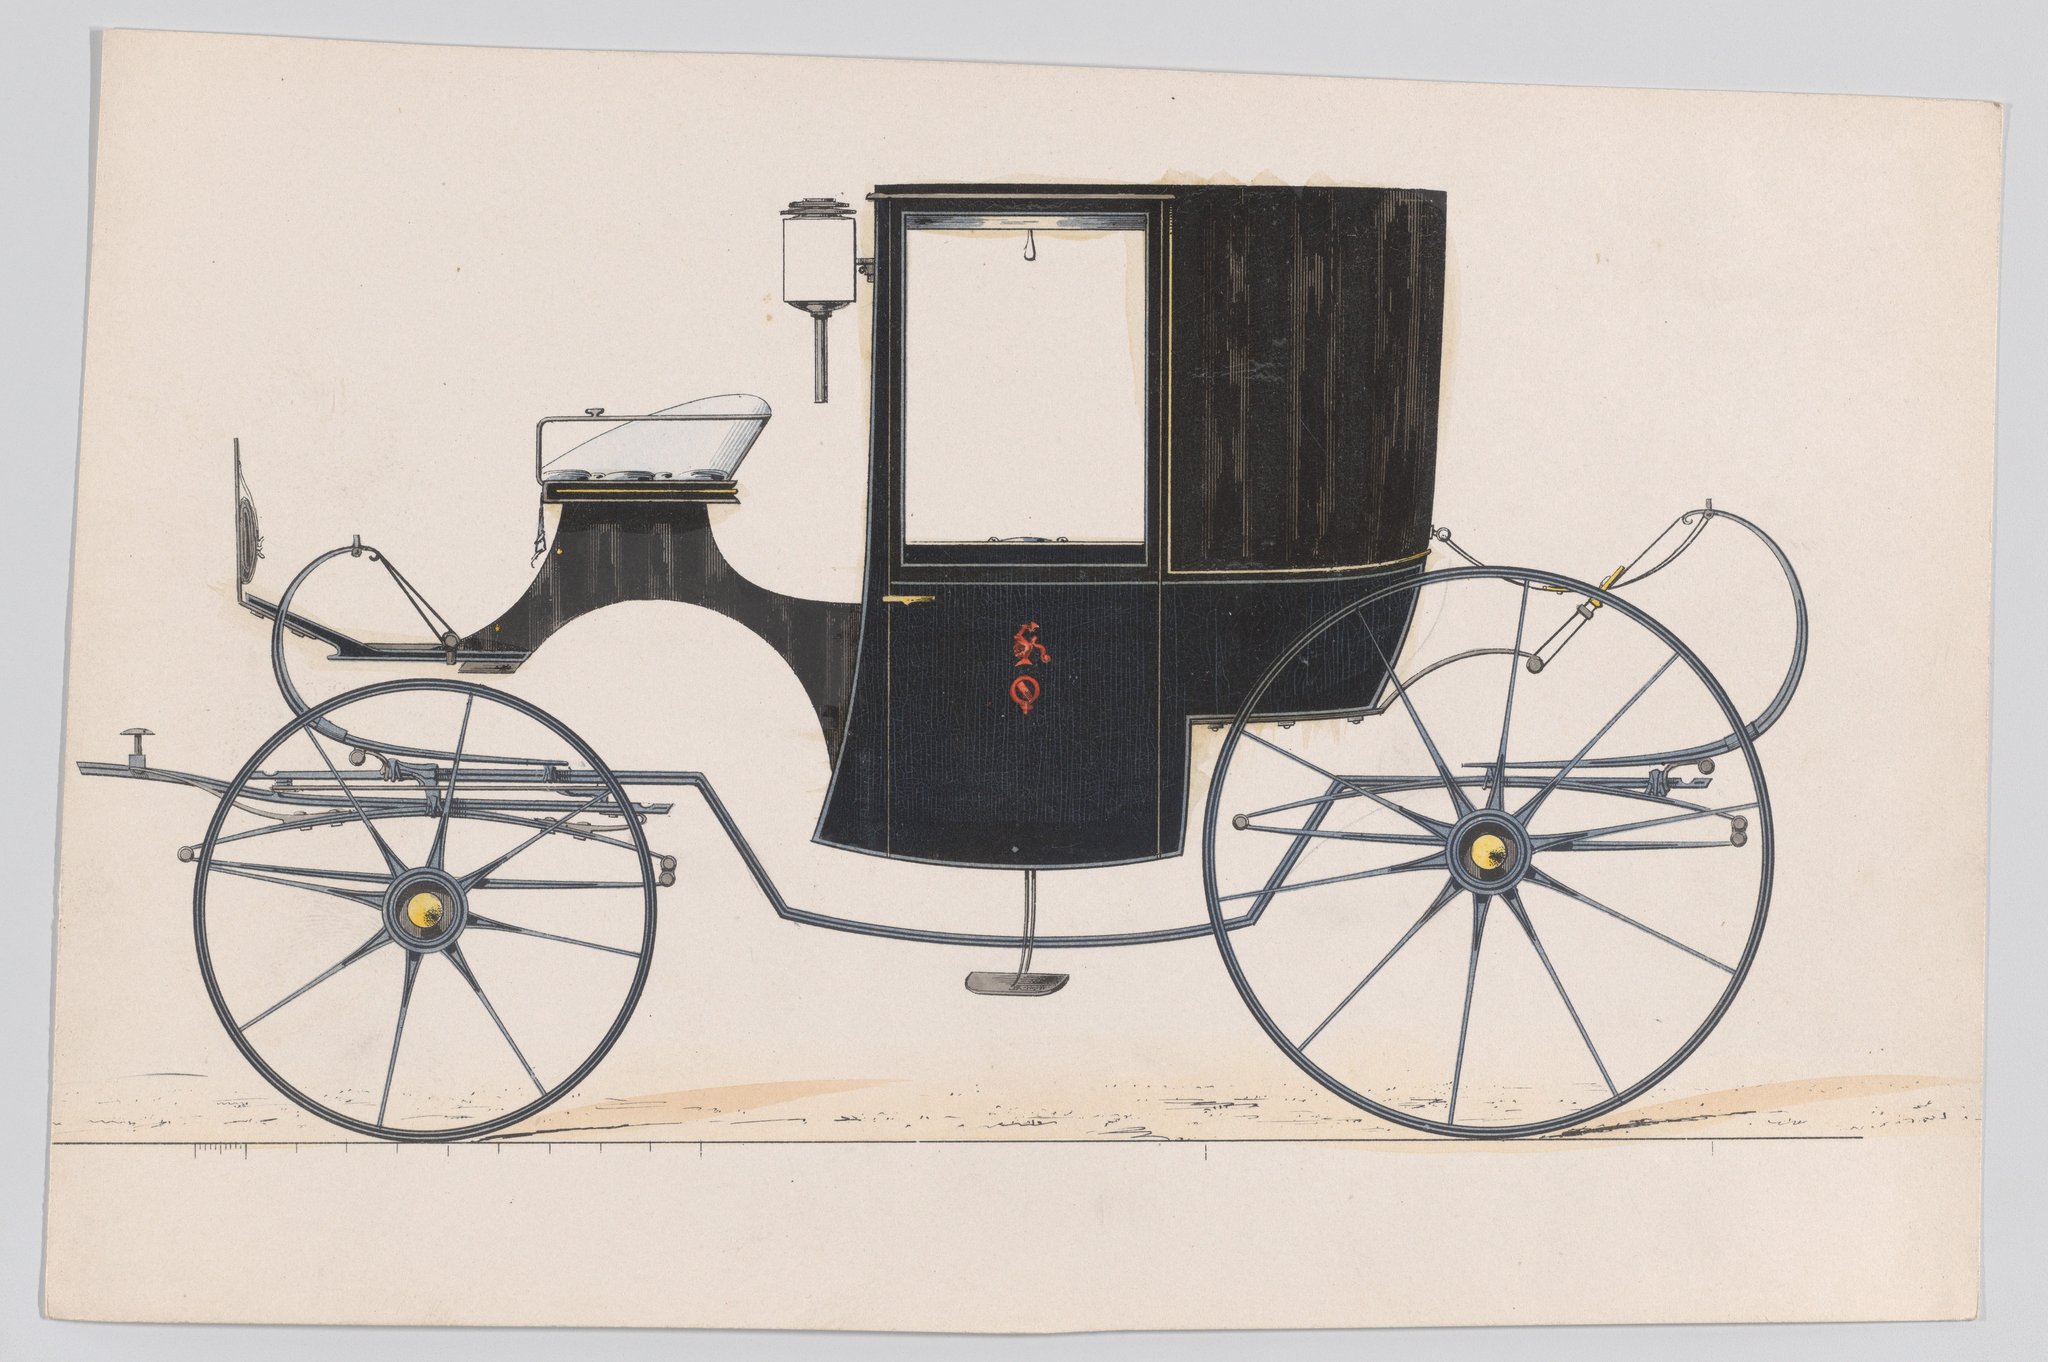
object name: print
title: Design for Brougham/D'Orsay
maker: anonymous, french, 19th century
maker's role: artist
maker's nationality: french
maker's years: 1800-1900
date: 1880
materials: gouache, gum arabic, ink, watercolor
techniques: pen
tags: carriages